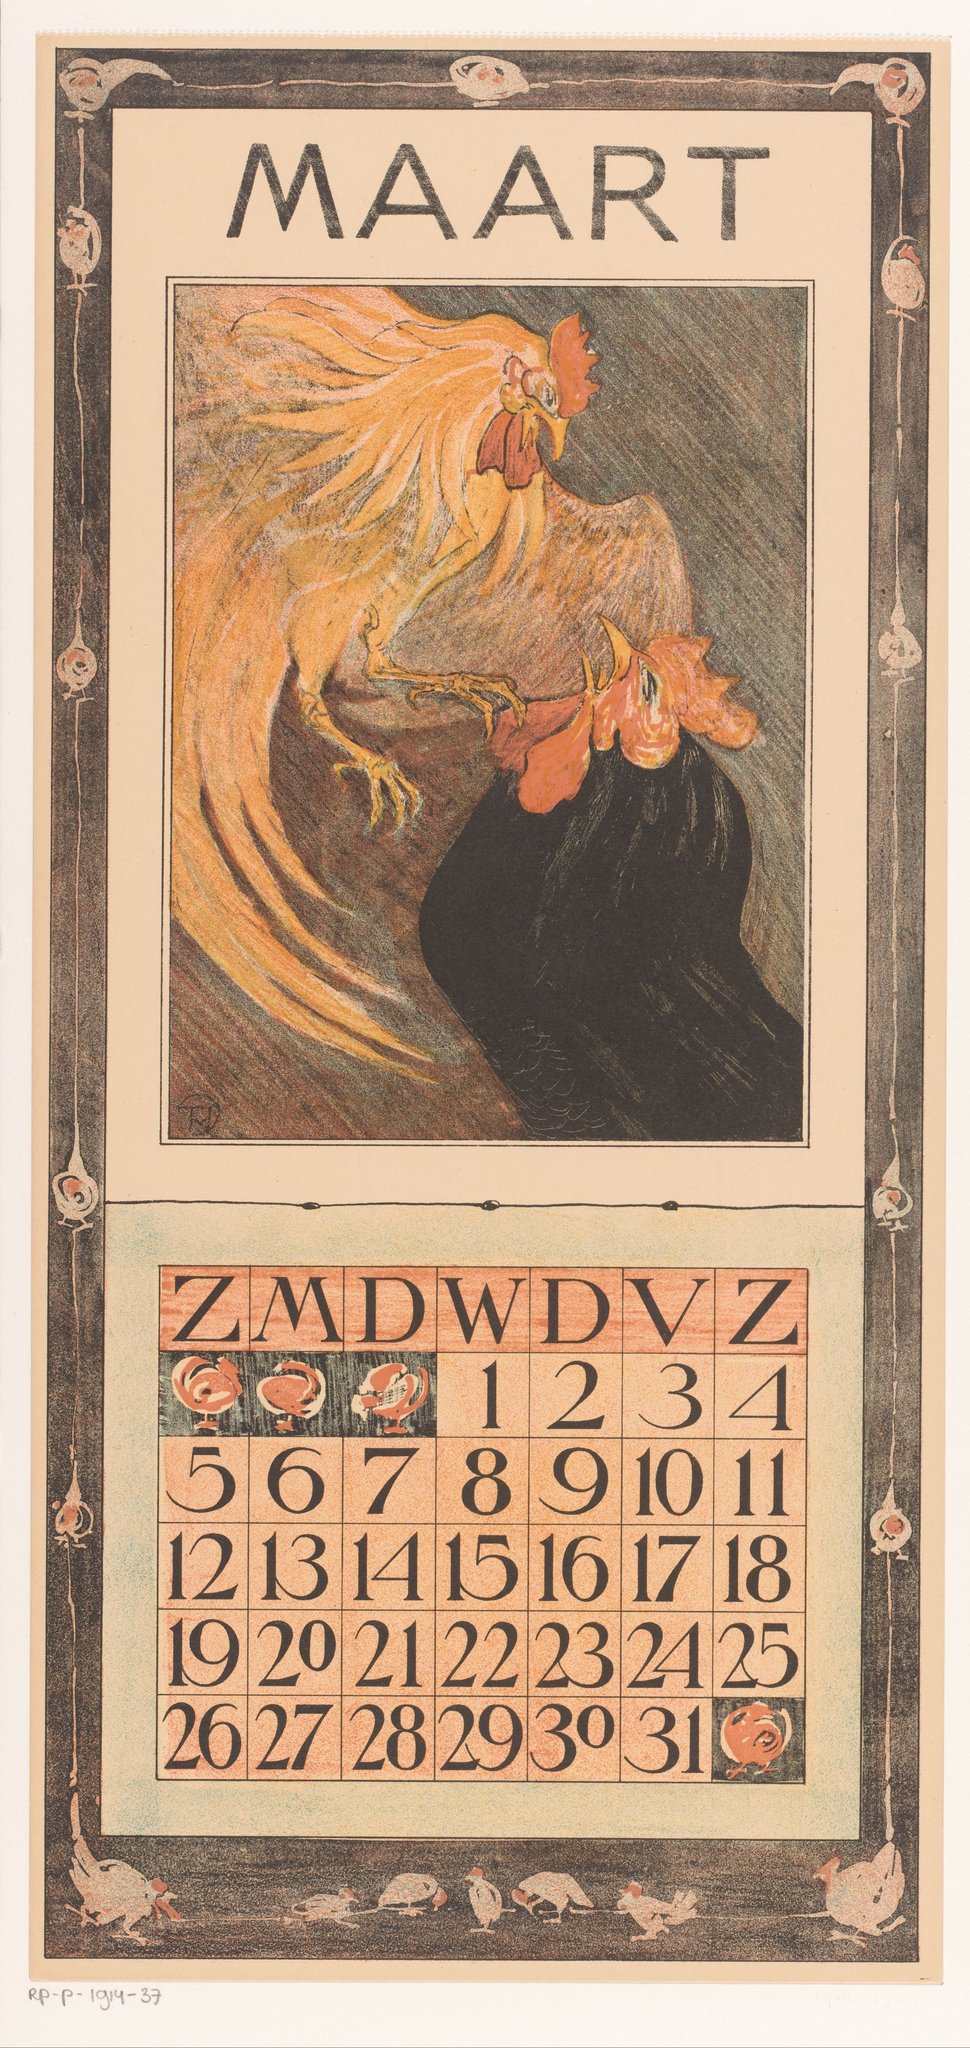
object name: calendar leaf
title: Kalender 1905 12 lithografien door Th. v. Hoytema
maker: theo van hoytema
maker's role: draughtsman, painter, print maker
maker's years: 1863-1917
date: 1904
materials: paper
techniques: lithograph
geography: amsterdam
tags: cock-fighting, march ~ other concepts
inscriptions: collector's mark: Lugt 2228